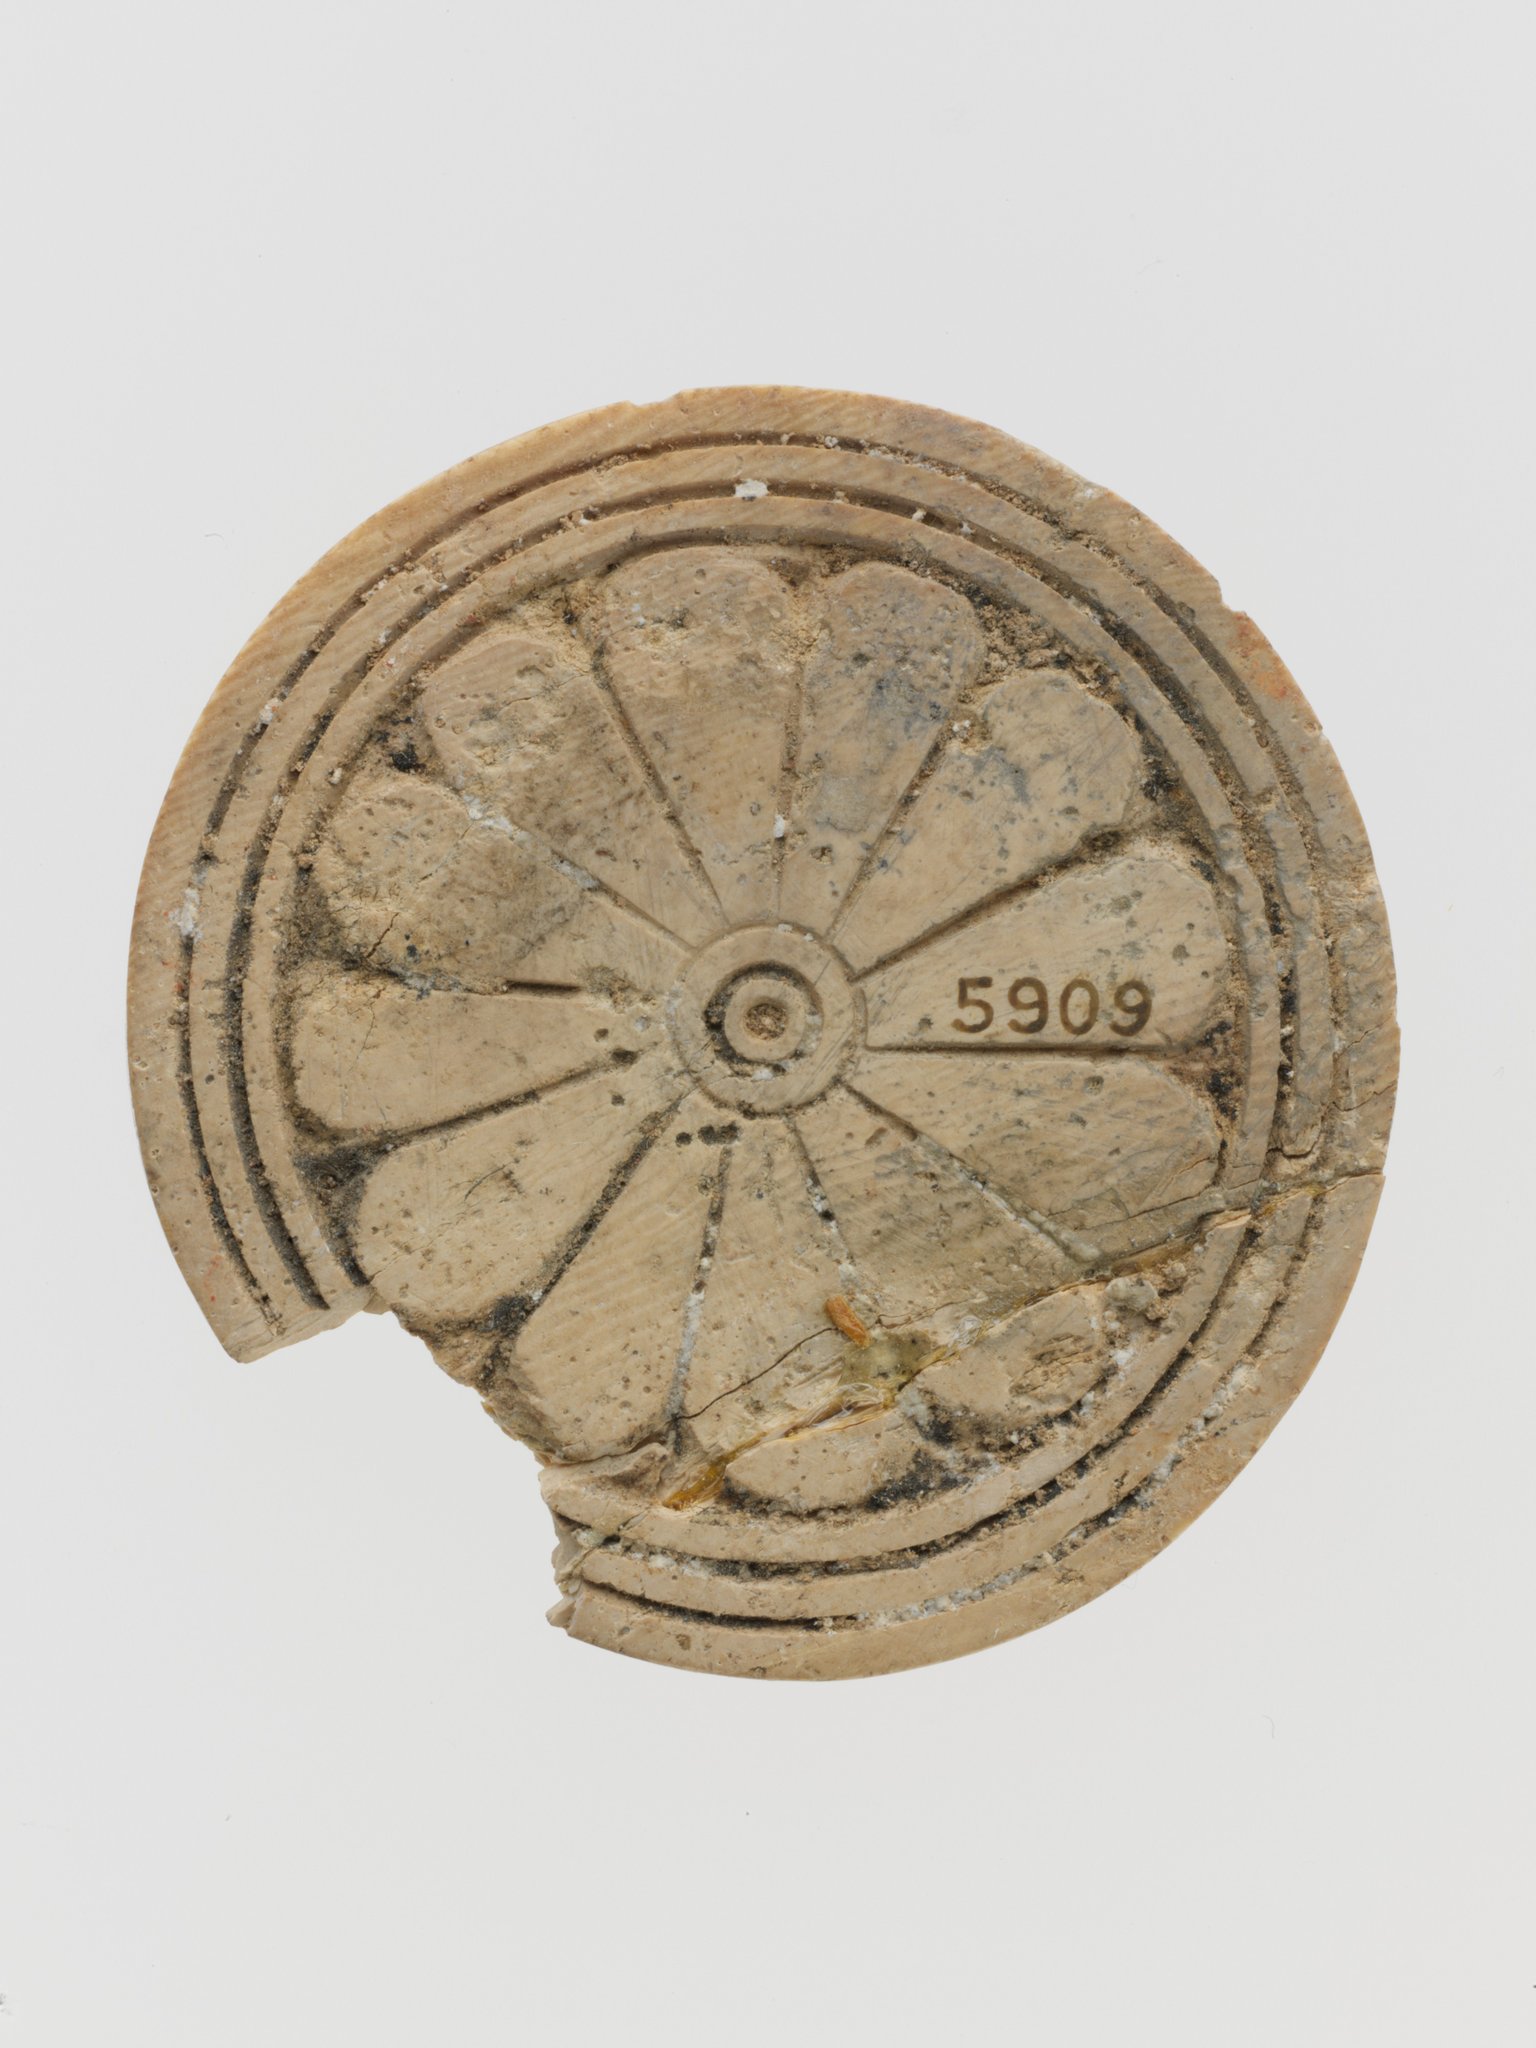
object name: roundel, disk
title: Ivory disk of a pyxis with rosette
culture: cypriot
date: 1300-1101 BCE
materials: ivory